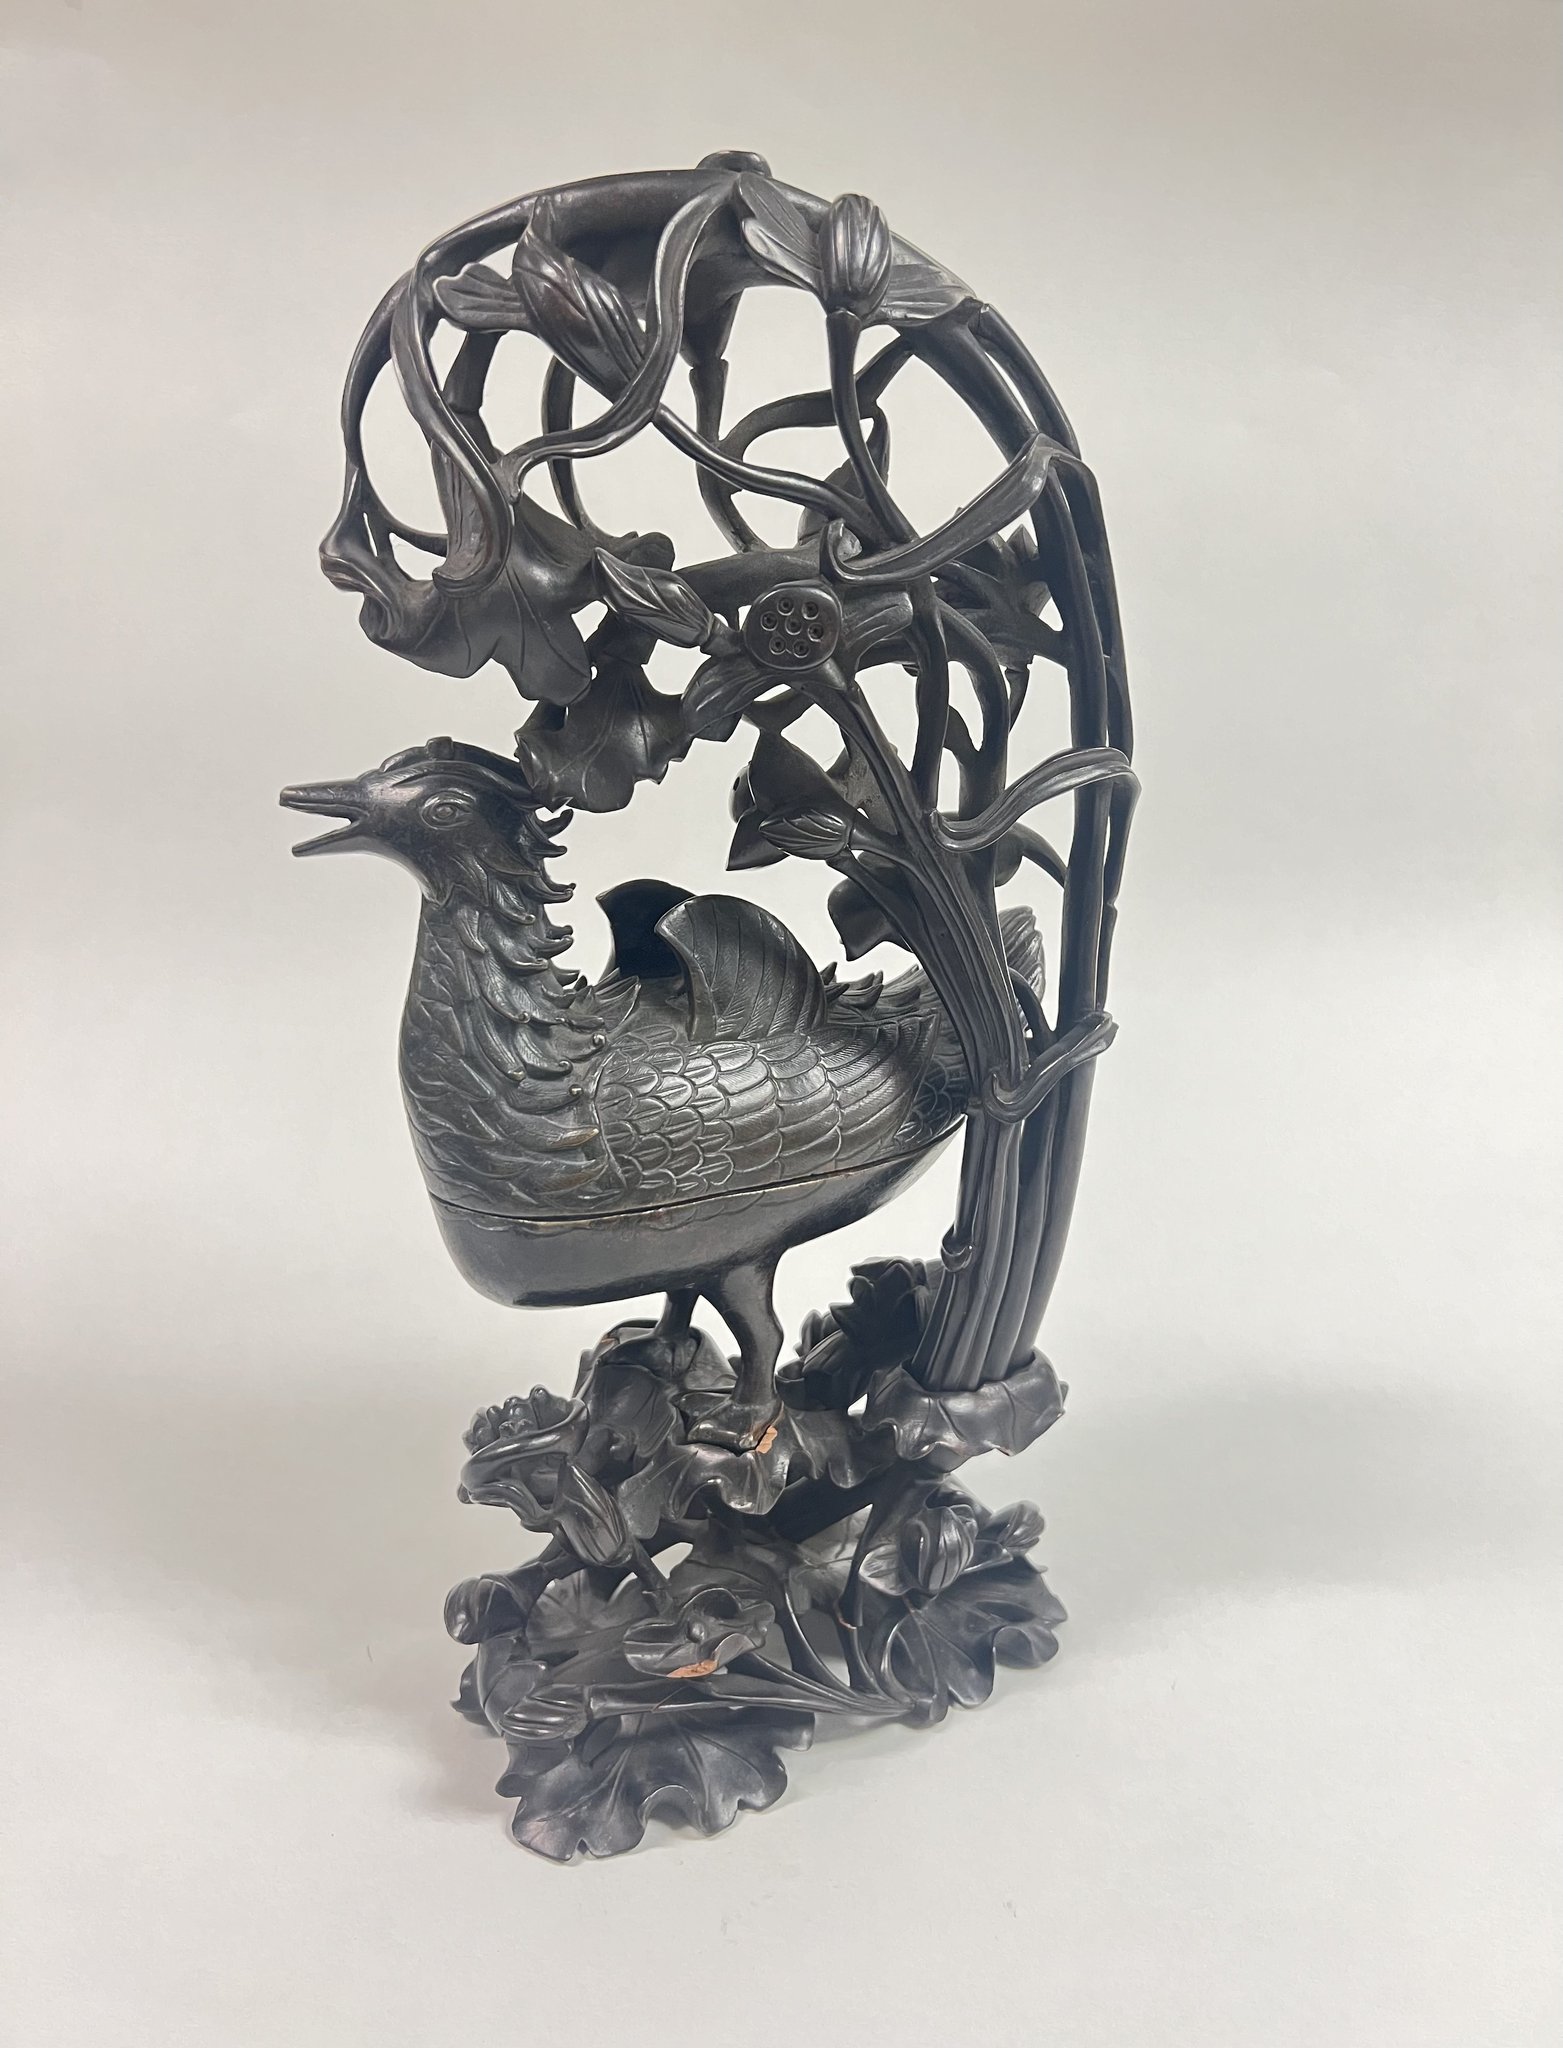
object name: bowl with cover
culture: japanese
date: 1734-1900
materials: bronze